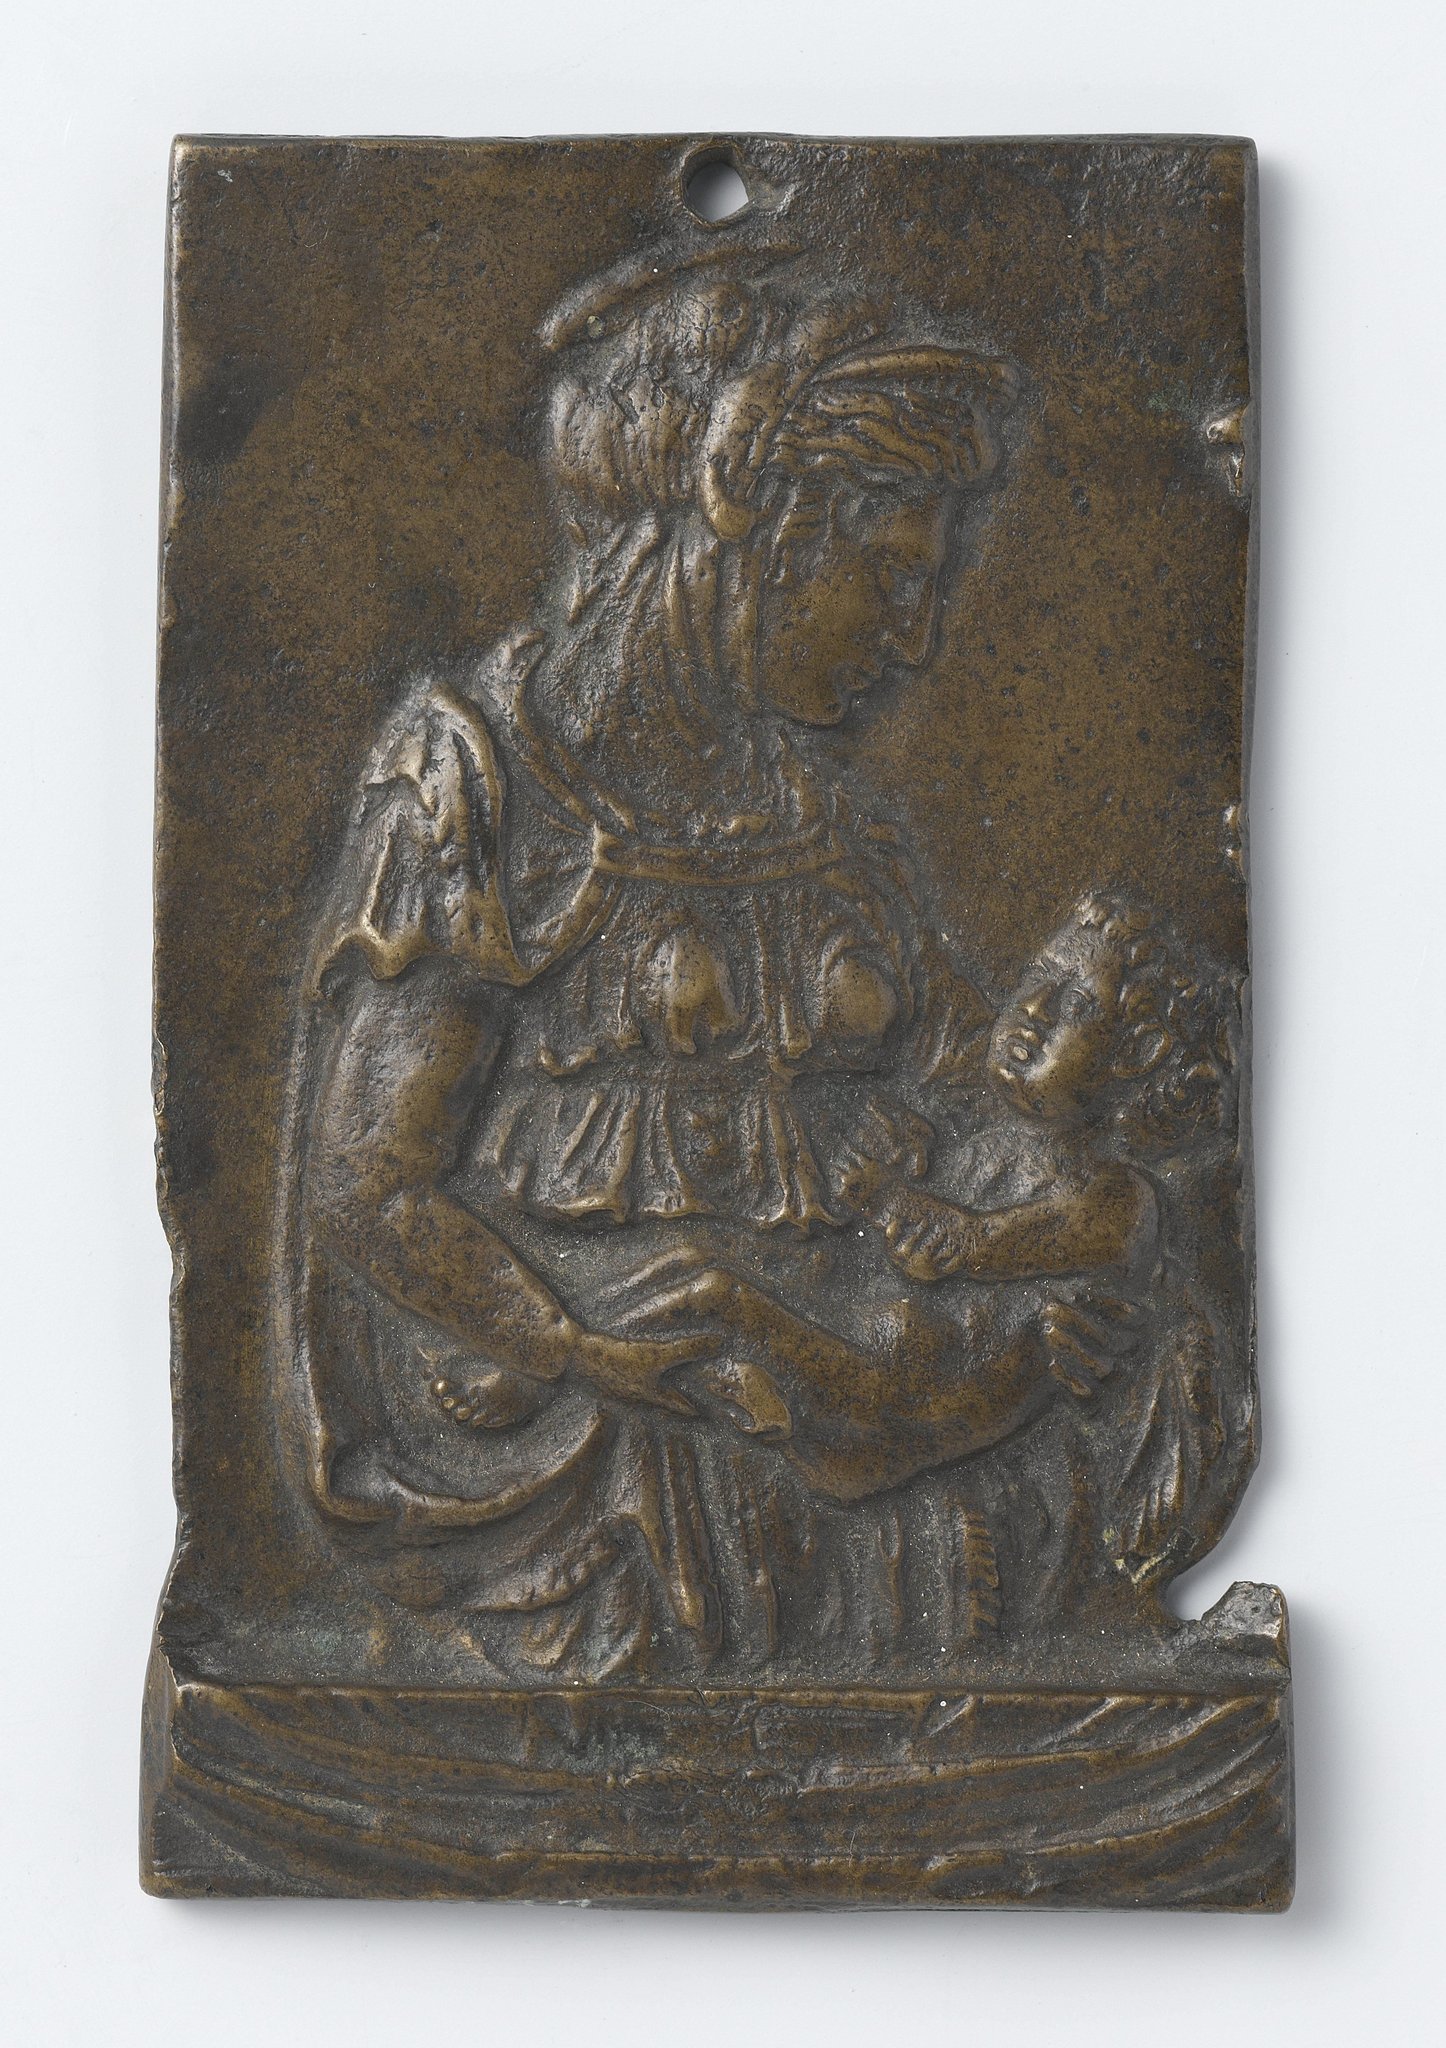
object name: plaque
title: Maria met kind, kniestuk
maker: donatello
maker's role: sculptor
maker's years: 1386-1466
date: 1386-1466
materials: bronze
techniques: casting, metalworking, patinaed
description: Maria staat driekwart naar rechts met het hoofd in profiel achter een balustrade, waarvoor een doek hangt. Het liggende naakte kind draagt zij op beide handen. Zij draagt een diadeem en over het hoofd en om de kin een sluier, voorts een gegord kleed en een mantel, die voor de borst wordt samengehouden. Maria heeft een nimbus.